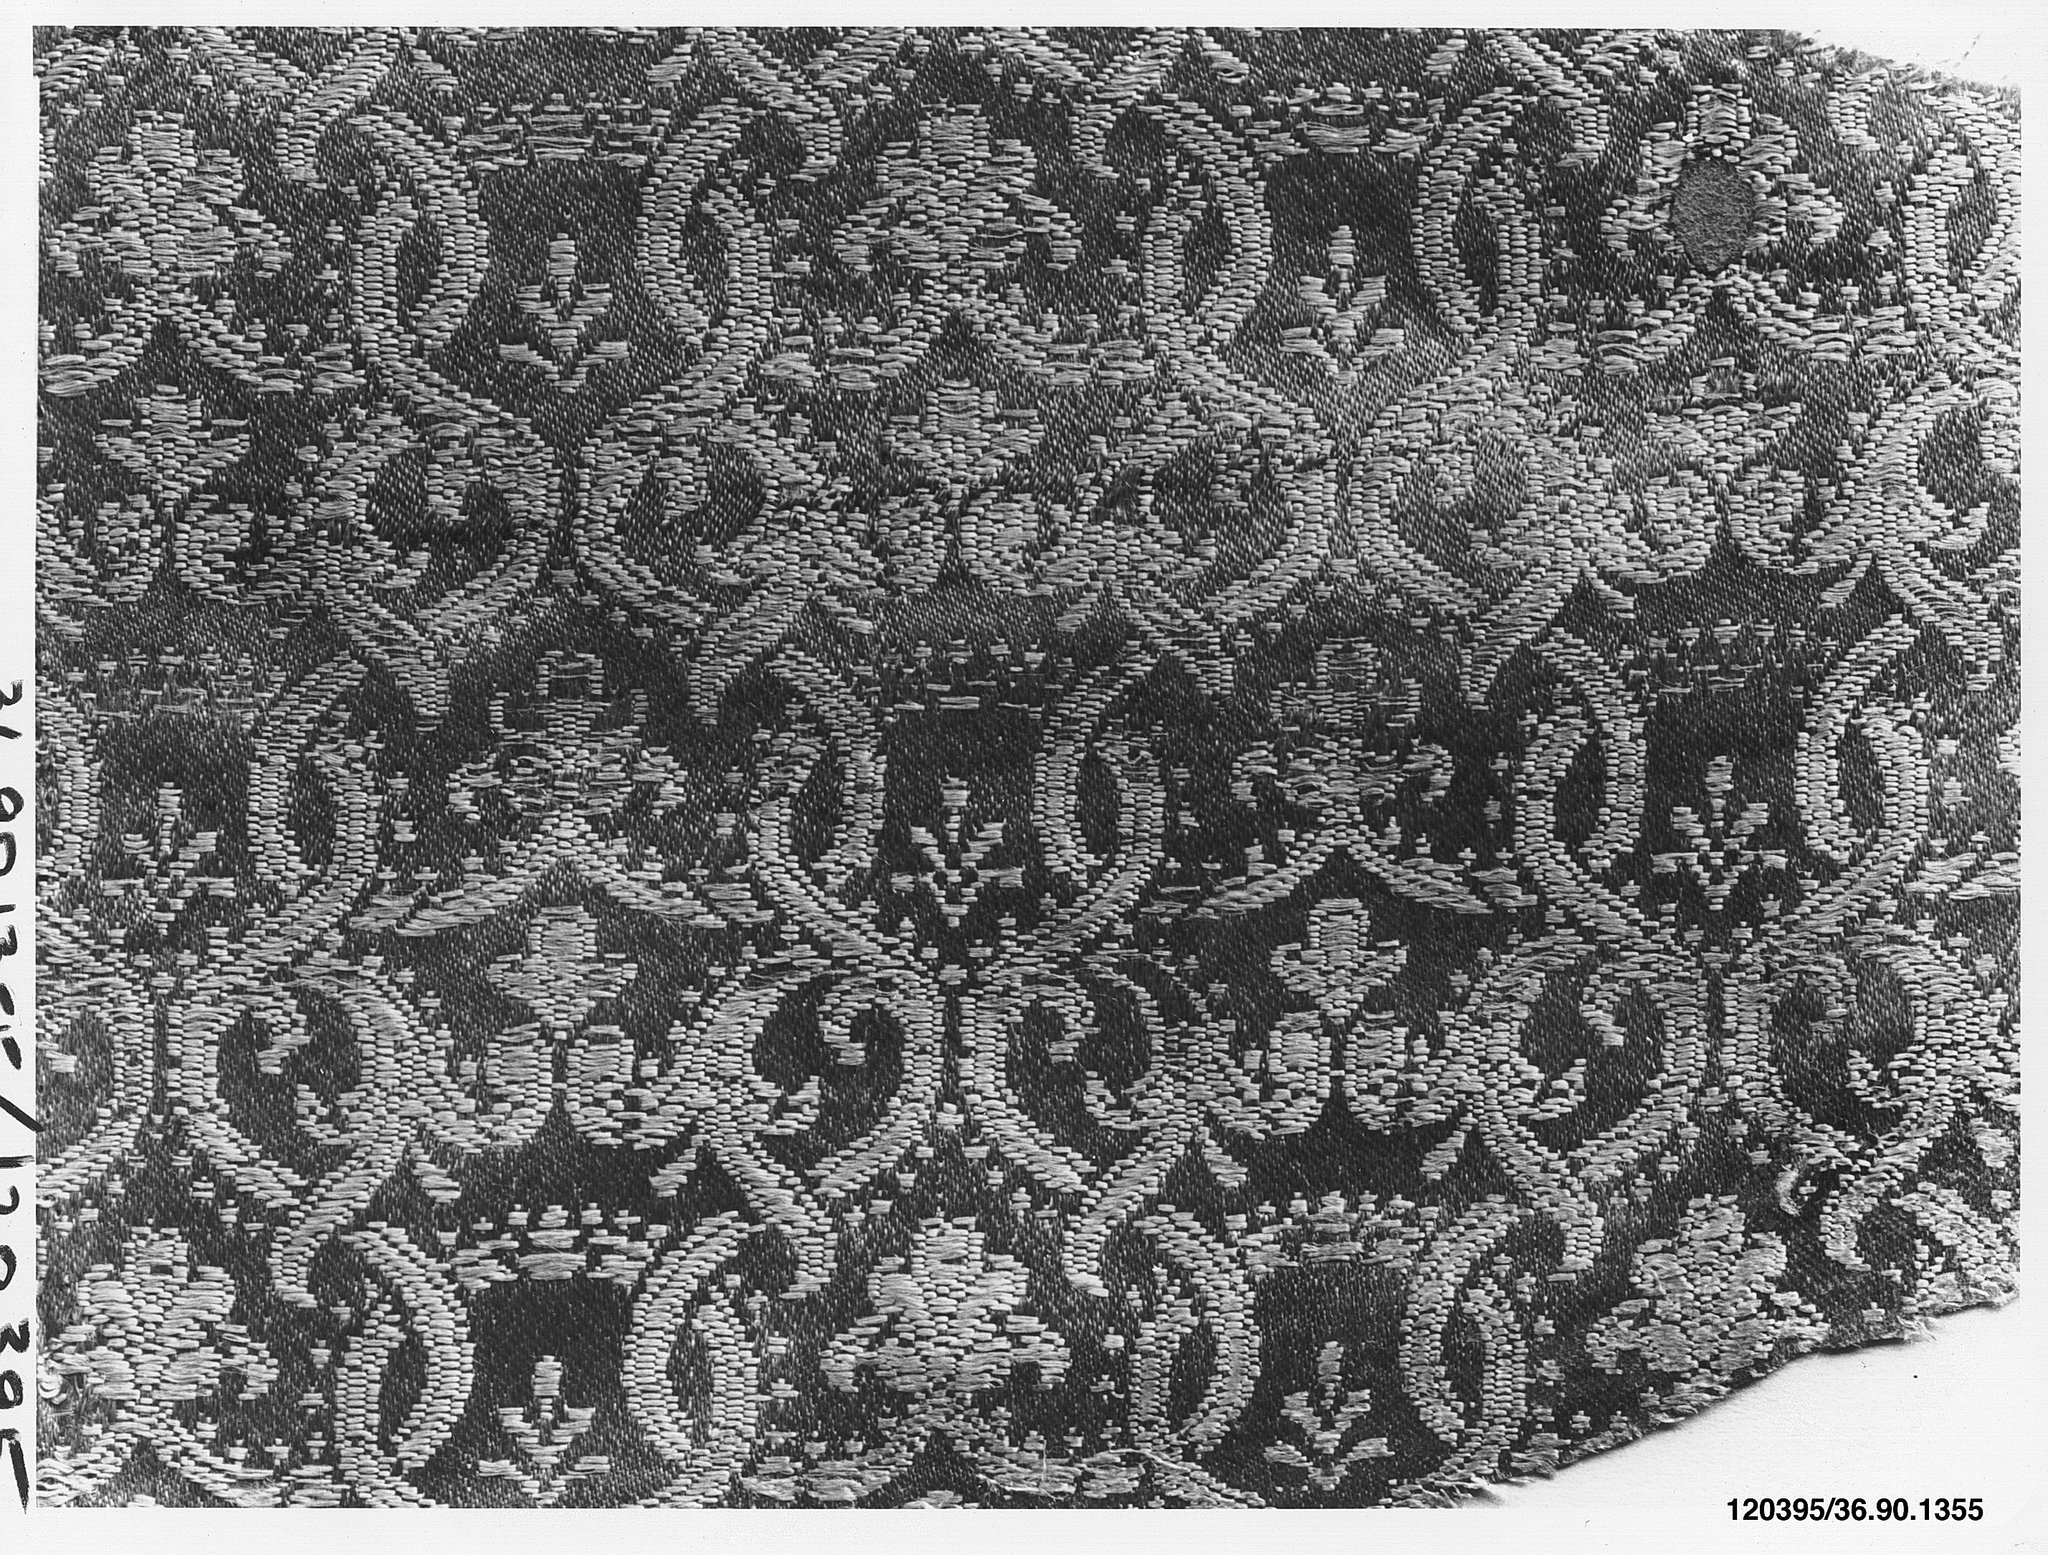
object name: piece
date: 1501-1700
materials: silk